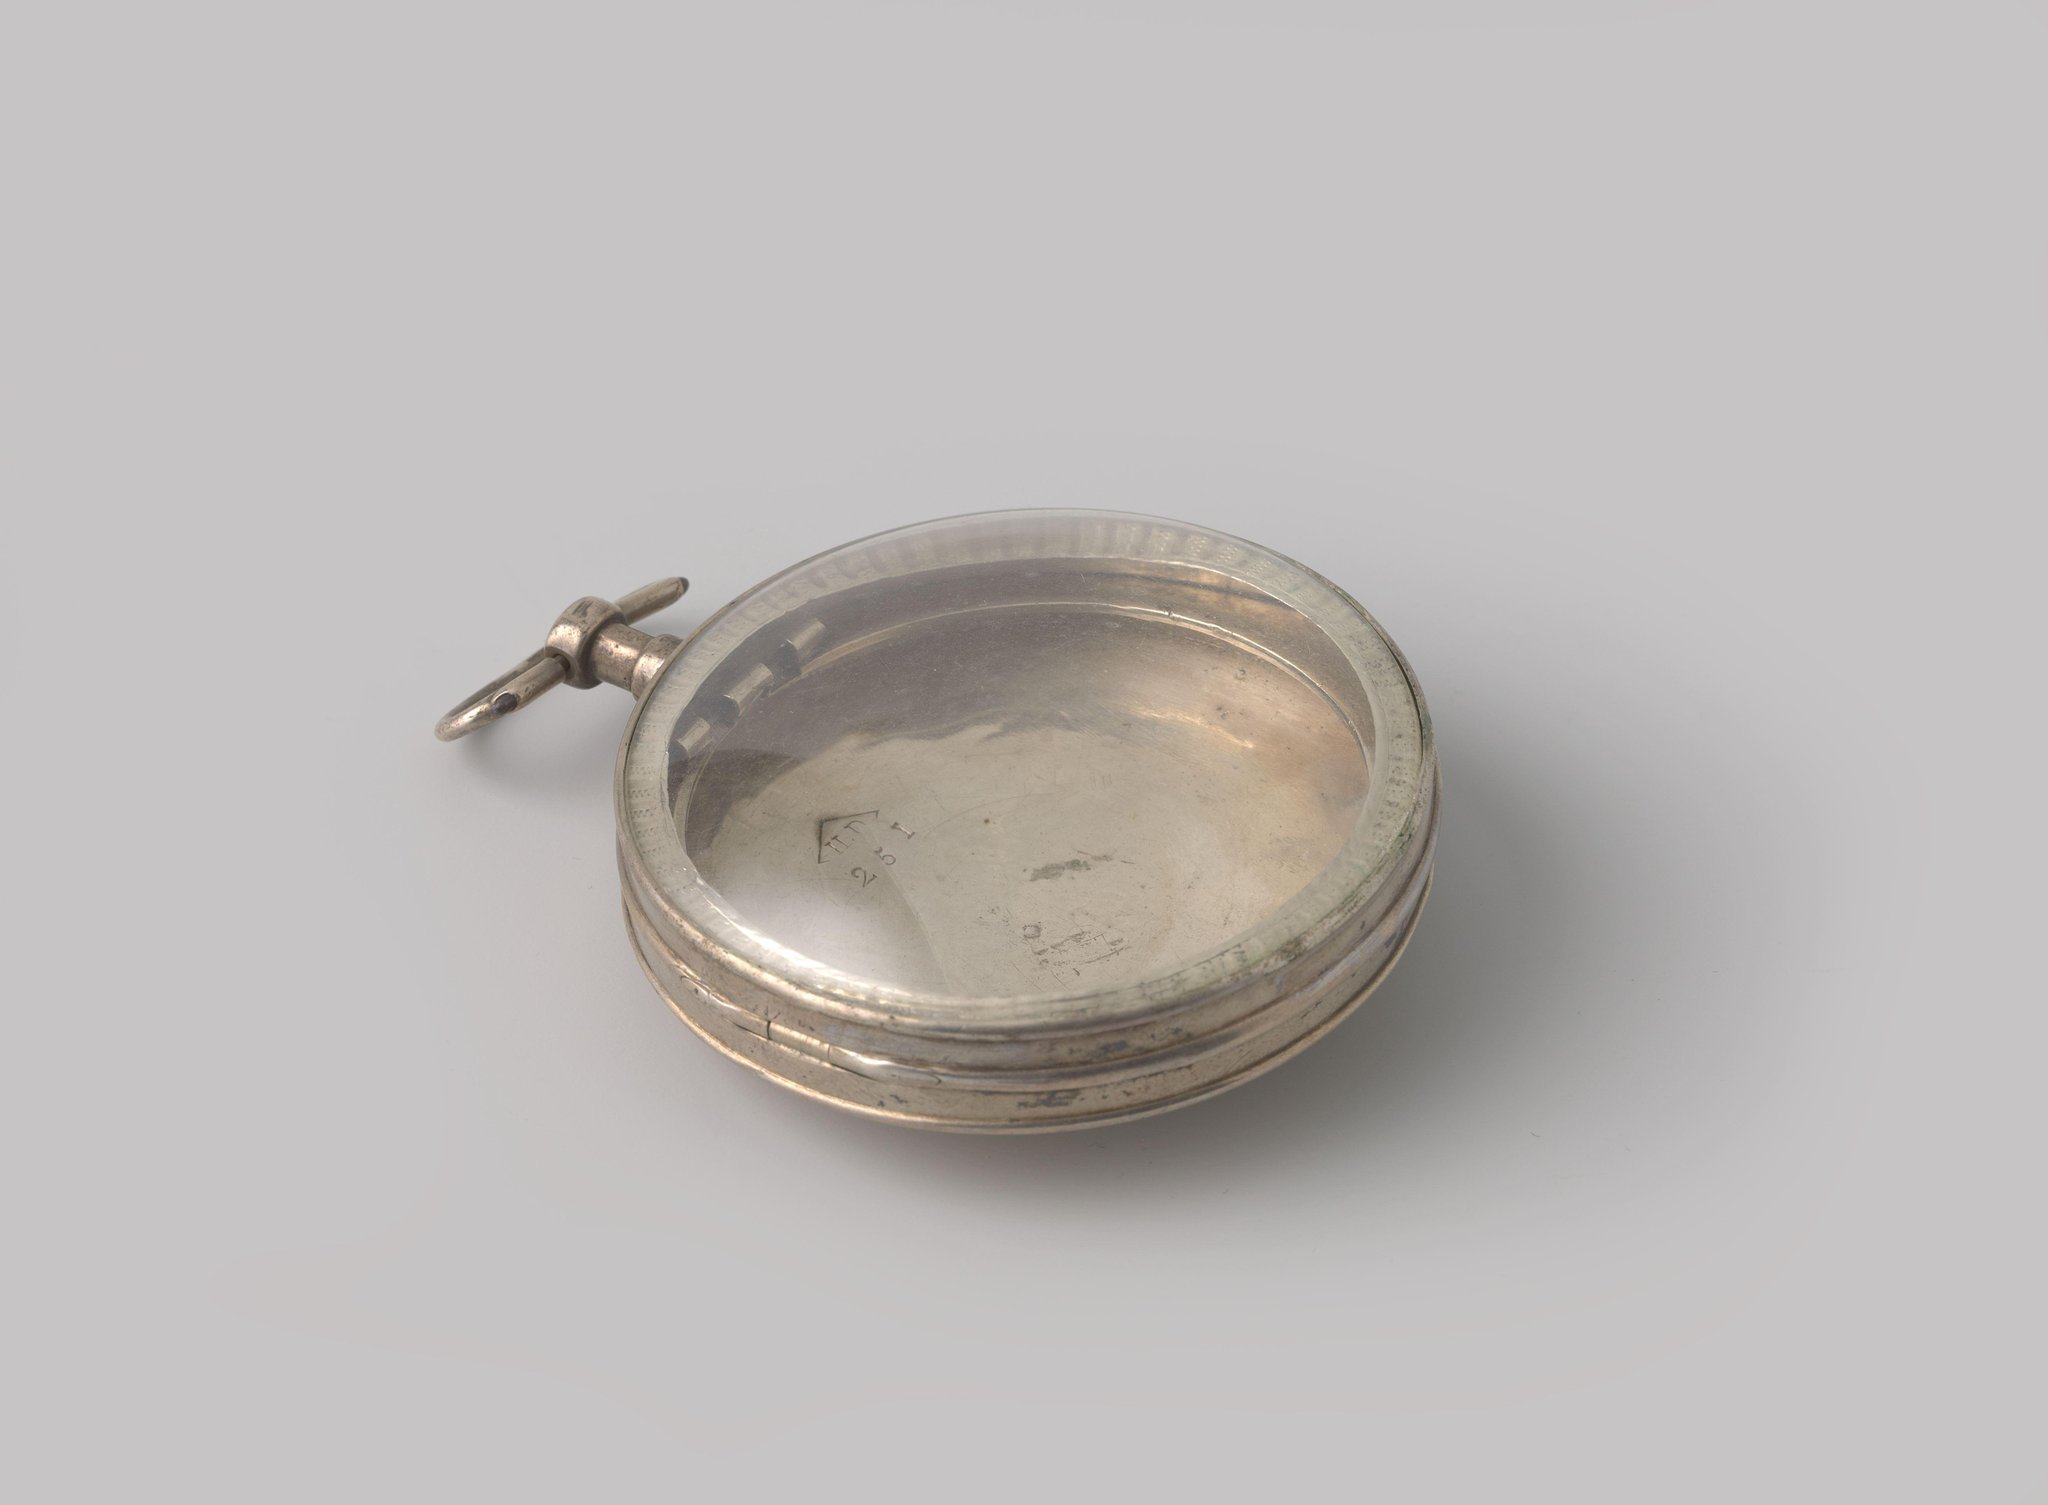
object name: jewellery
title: Kast van horloge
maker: Anonymous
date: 1850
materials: silver